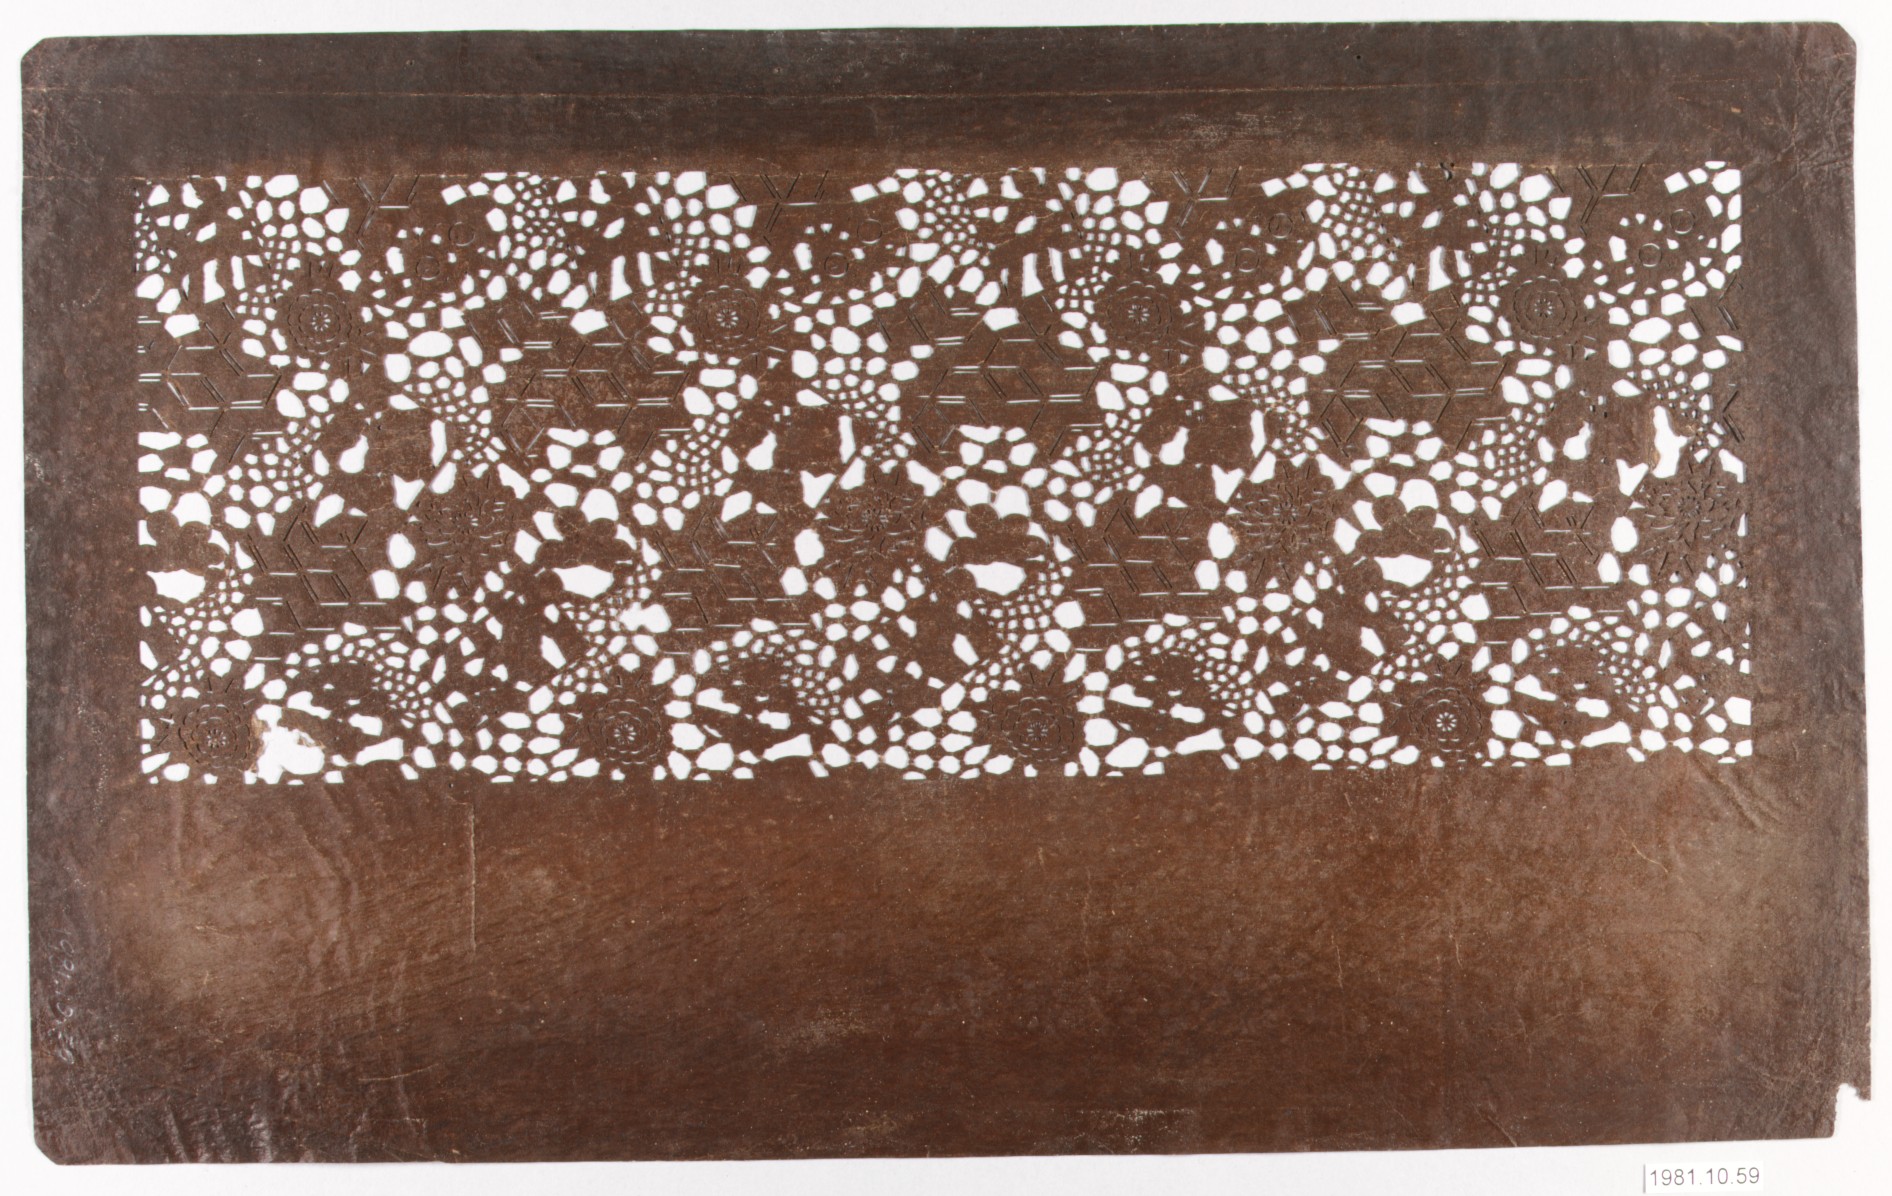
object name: stencil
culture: japanese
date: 1801-1900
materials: paper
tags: flowers